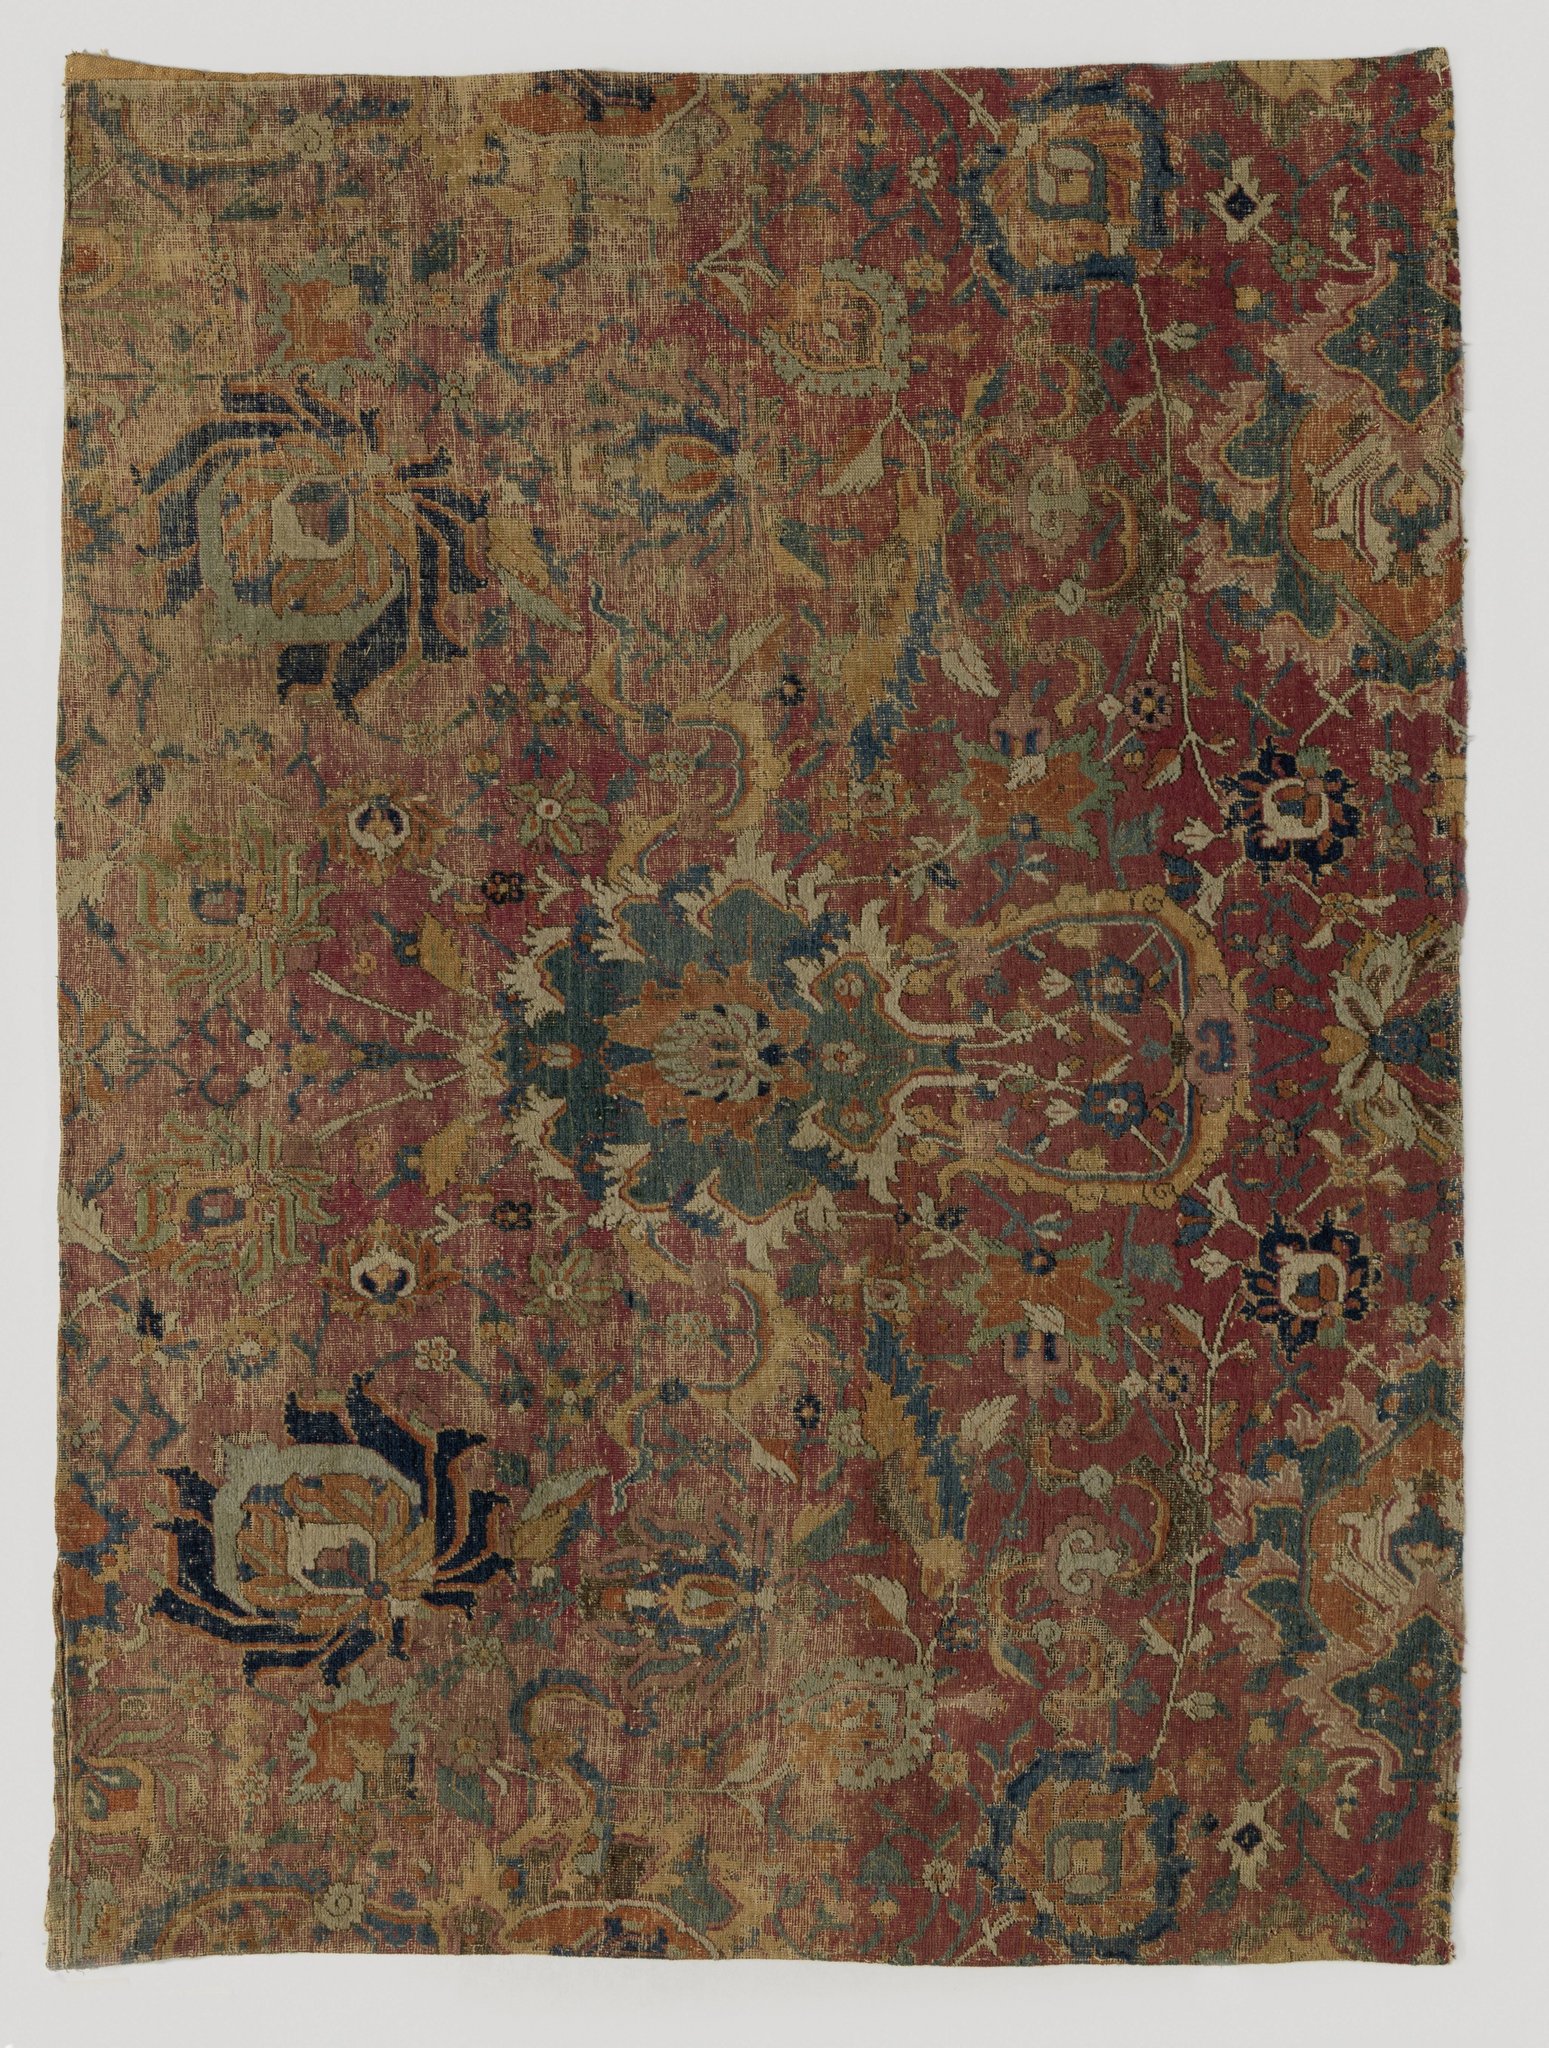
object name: oriental rug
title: Fragment van een lotus- en palmetbloemenkleed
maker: Anonymous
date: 1600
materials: wool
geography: herat